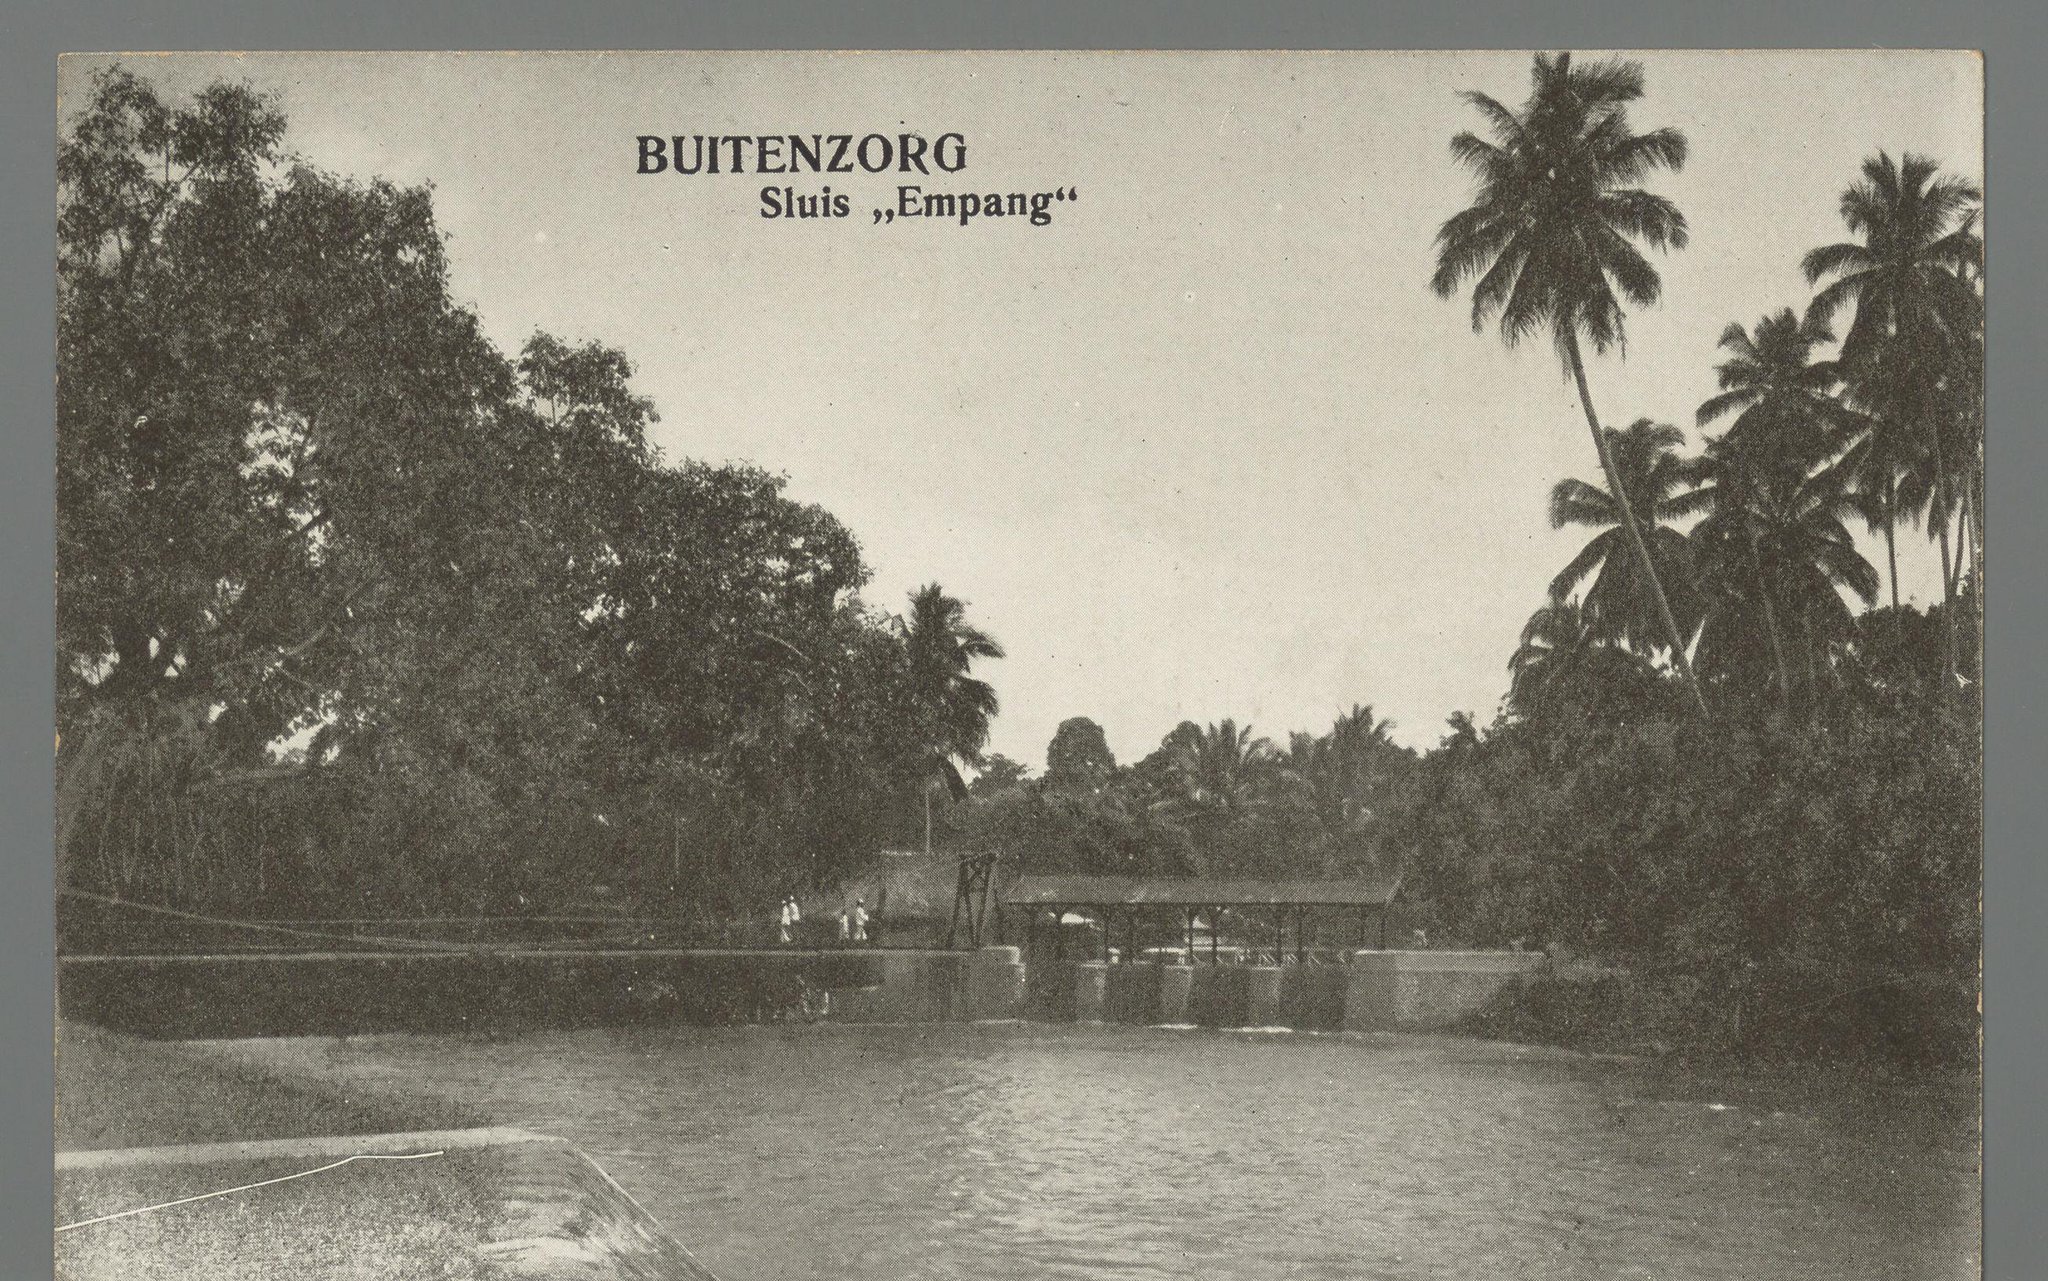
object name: photomechanical print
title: Buitenzorg. Sluis "Empang"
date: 1906-1930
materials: cardboard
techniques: autotype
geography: weltevreden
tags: sluice, weir